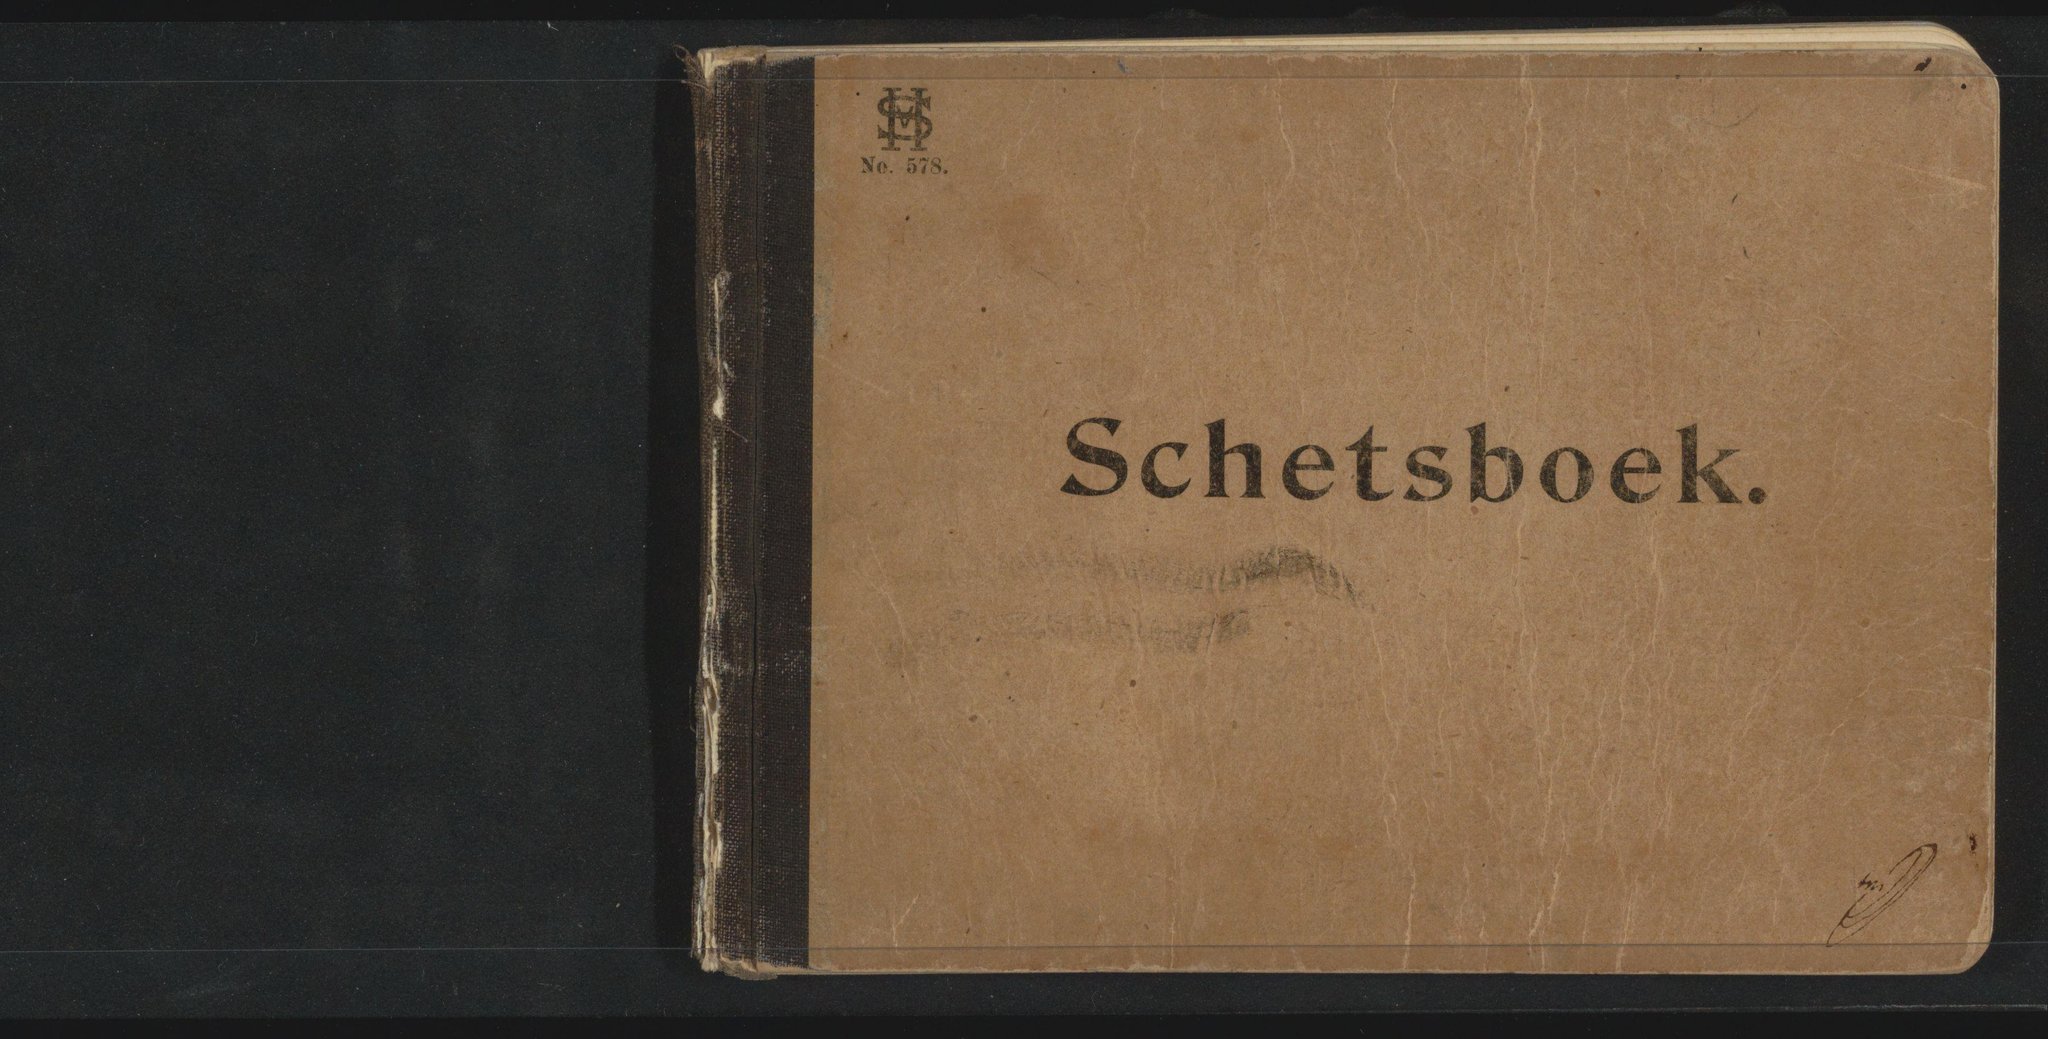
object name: sketchbook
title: Schetsboek met 19 bladen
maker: johanna van de kamer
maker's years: 1873-1922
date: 1883-1922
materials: cardboard, chalk, linen, paper, pencil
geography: katwijk aan zee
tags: katwijk aan zee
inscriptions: annotation: ‘22 x Katwijk a/Zee/ 2x paard/ I.A. van Schooten’, factory mark: ‘HvS/ No. 578.’, collector's mark: Lugt 2228a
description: Schetsboek bestaande uit 19 bladen met strandgezichten en een gezicht op Katwijk.